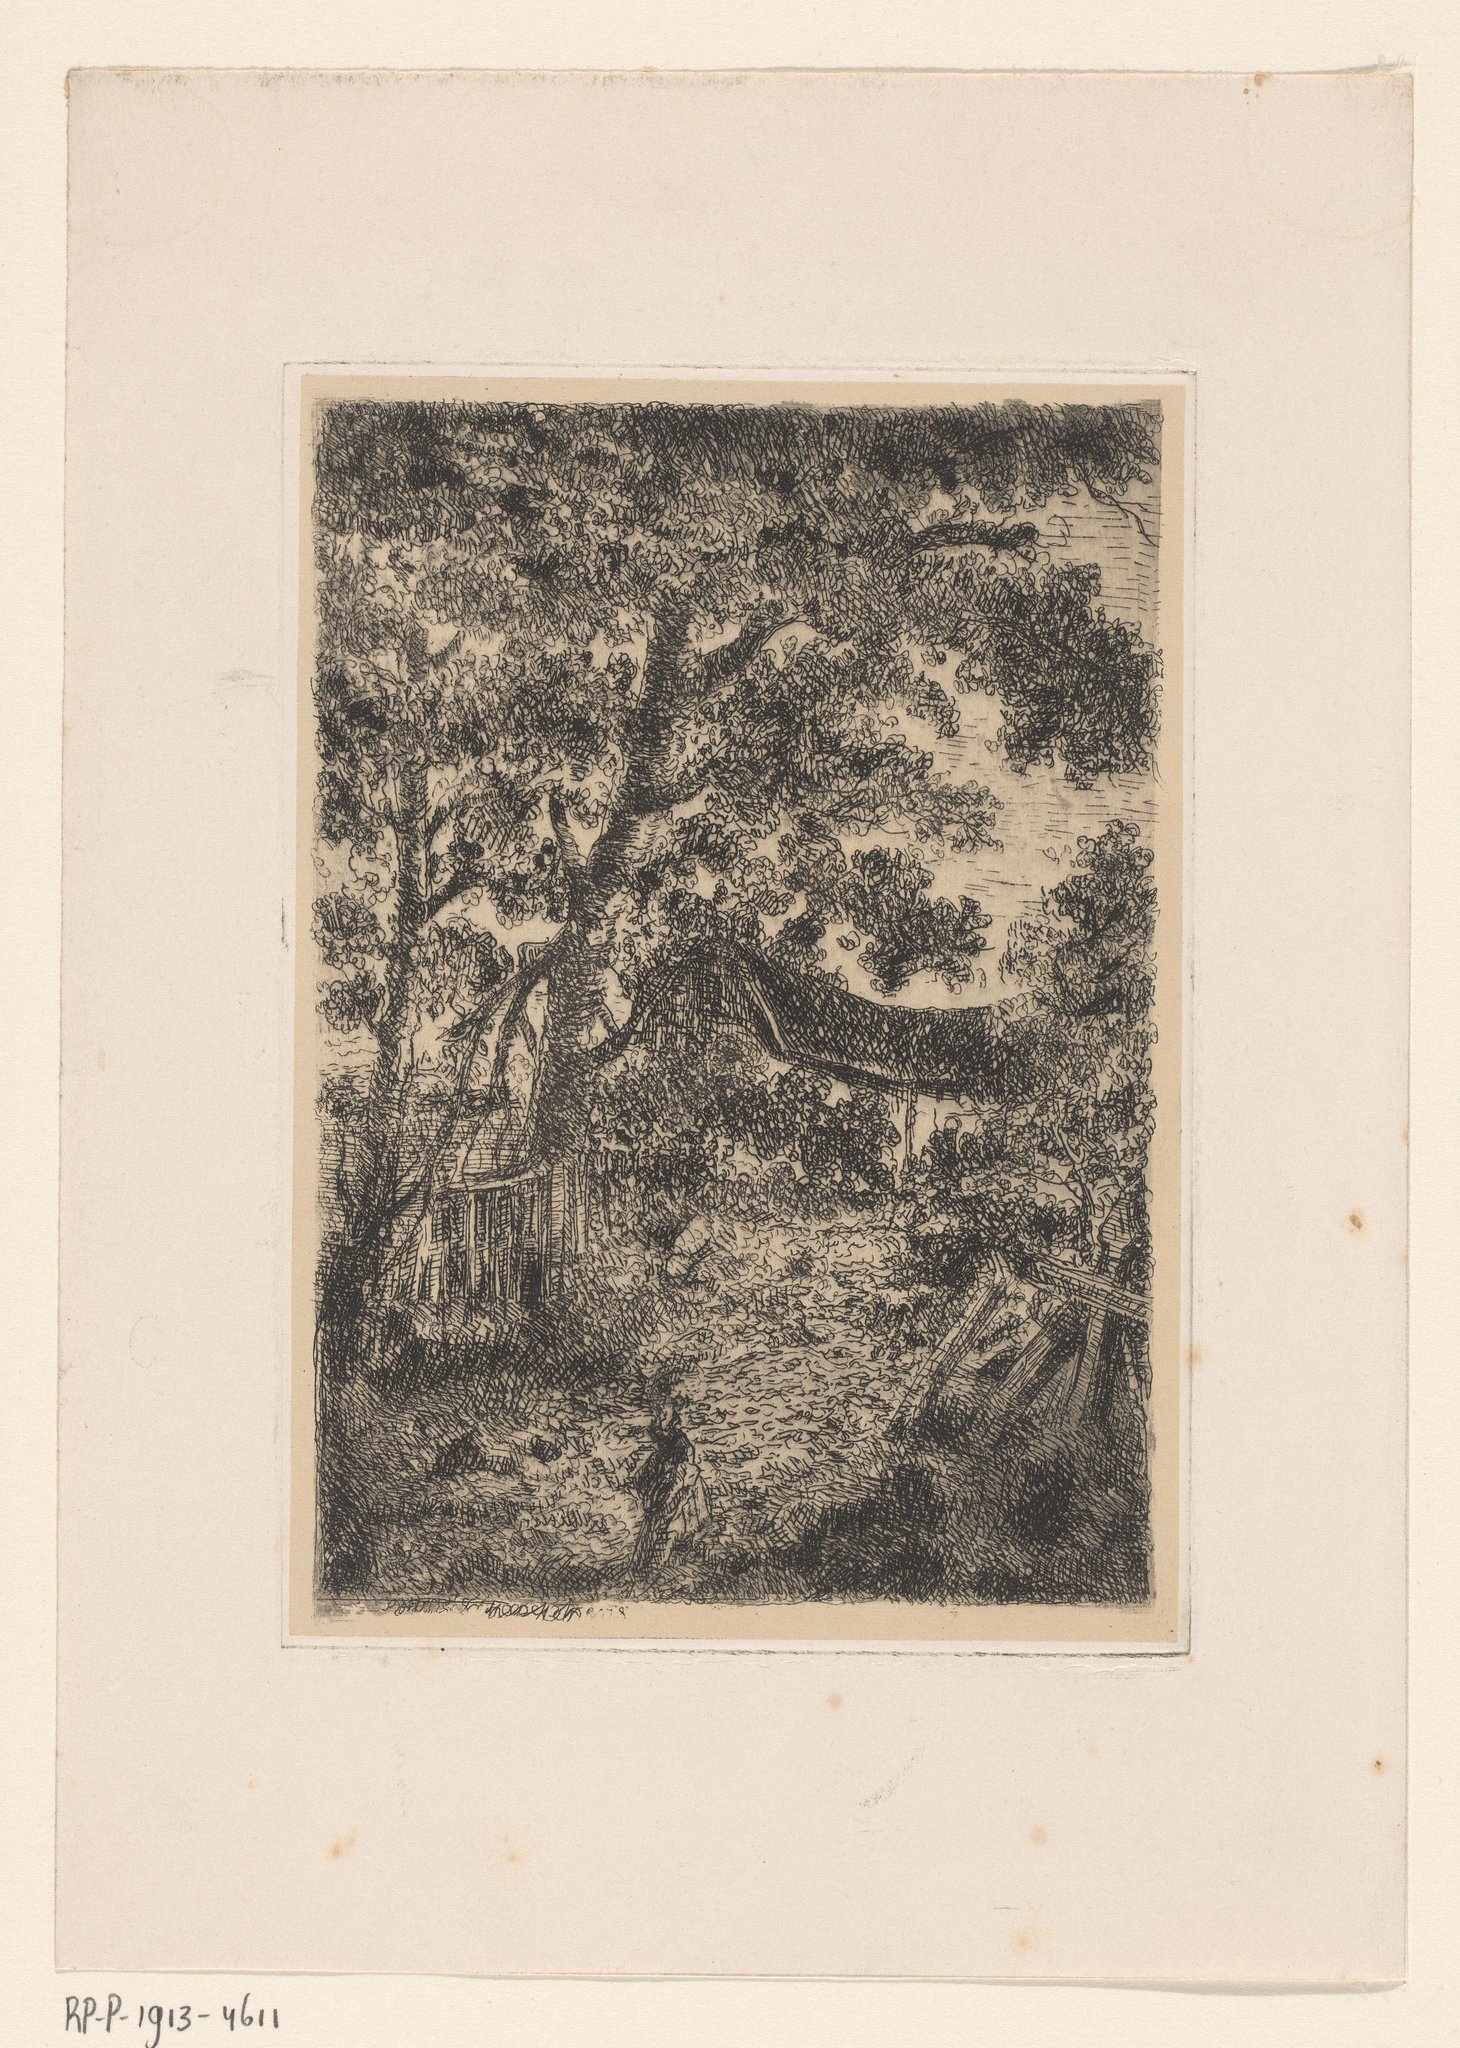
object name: print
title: Vrouw op een bospad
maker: arnoud schaepkens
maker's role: print maker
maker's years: 1816-1904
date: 1831-1904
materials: paper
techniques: etching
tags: forest path or lane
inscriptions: collector's mark: Lugt 2228